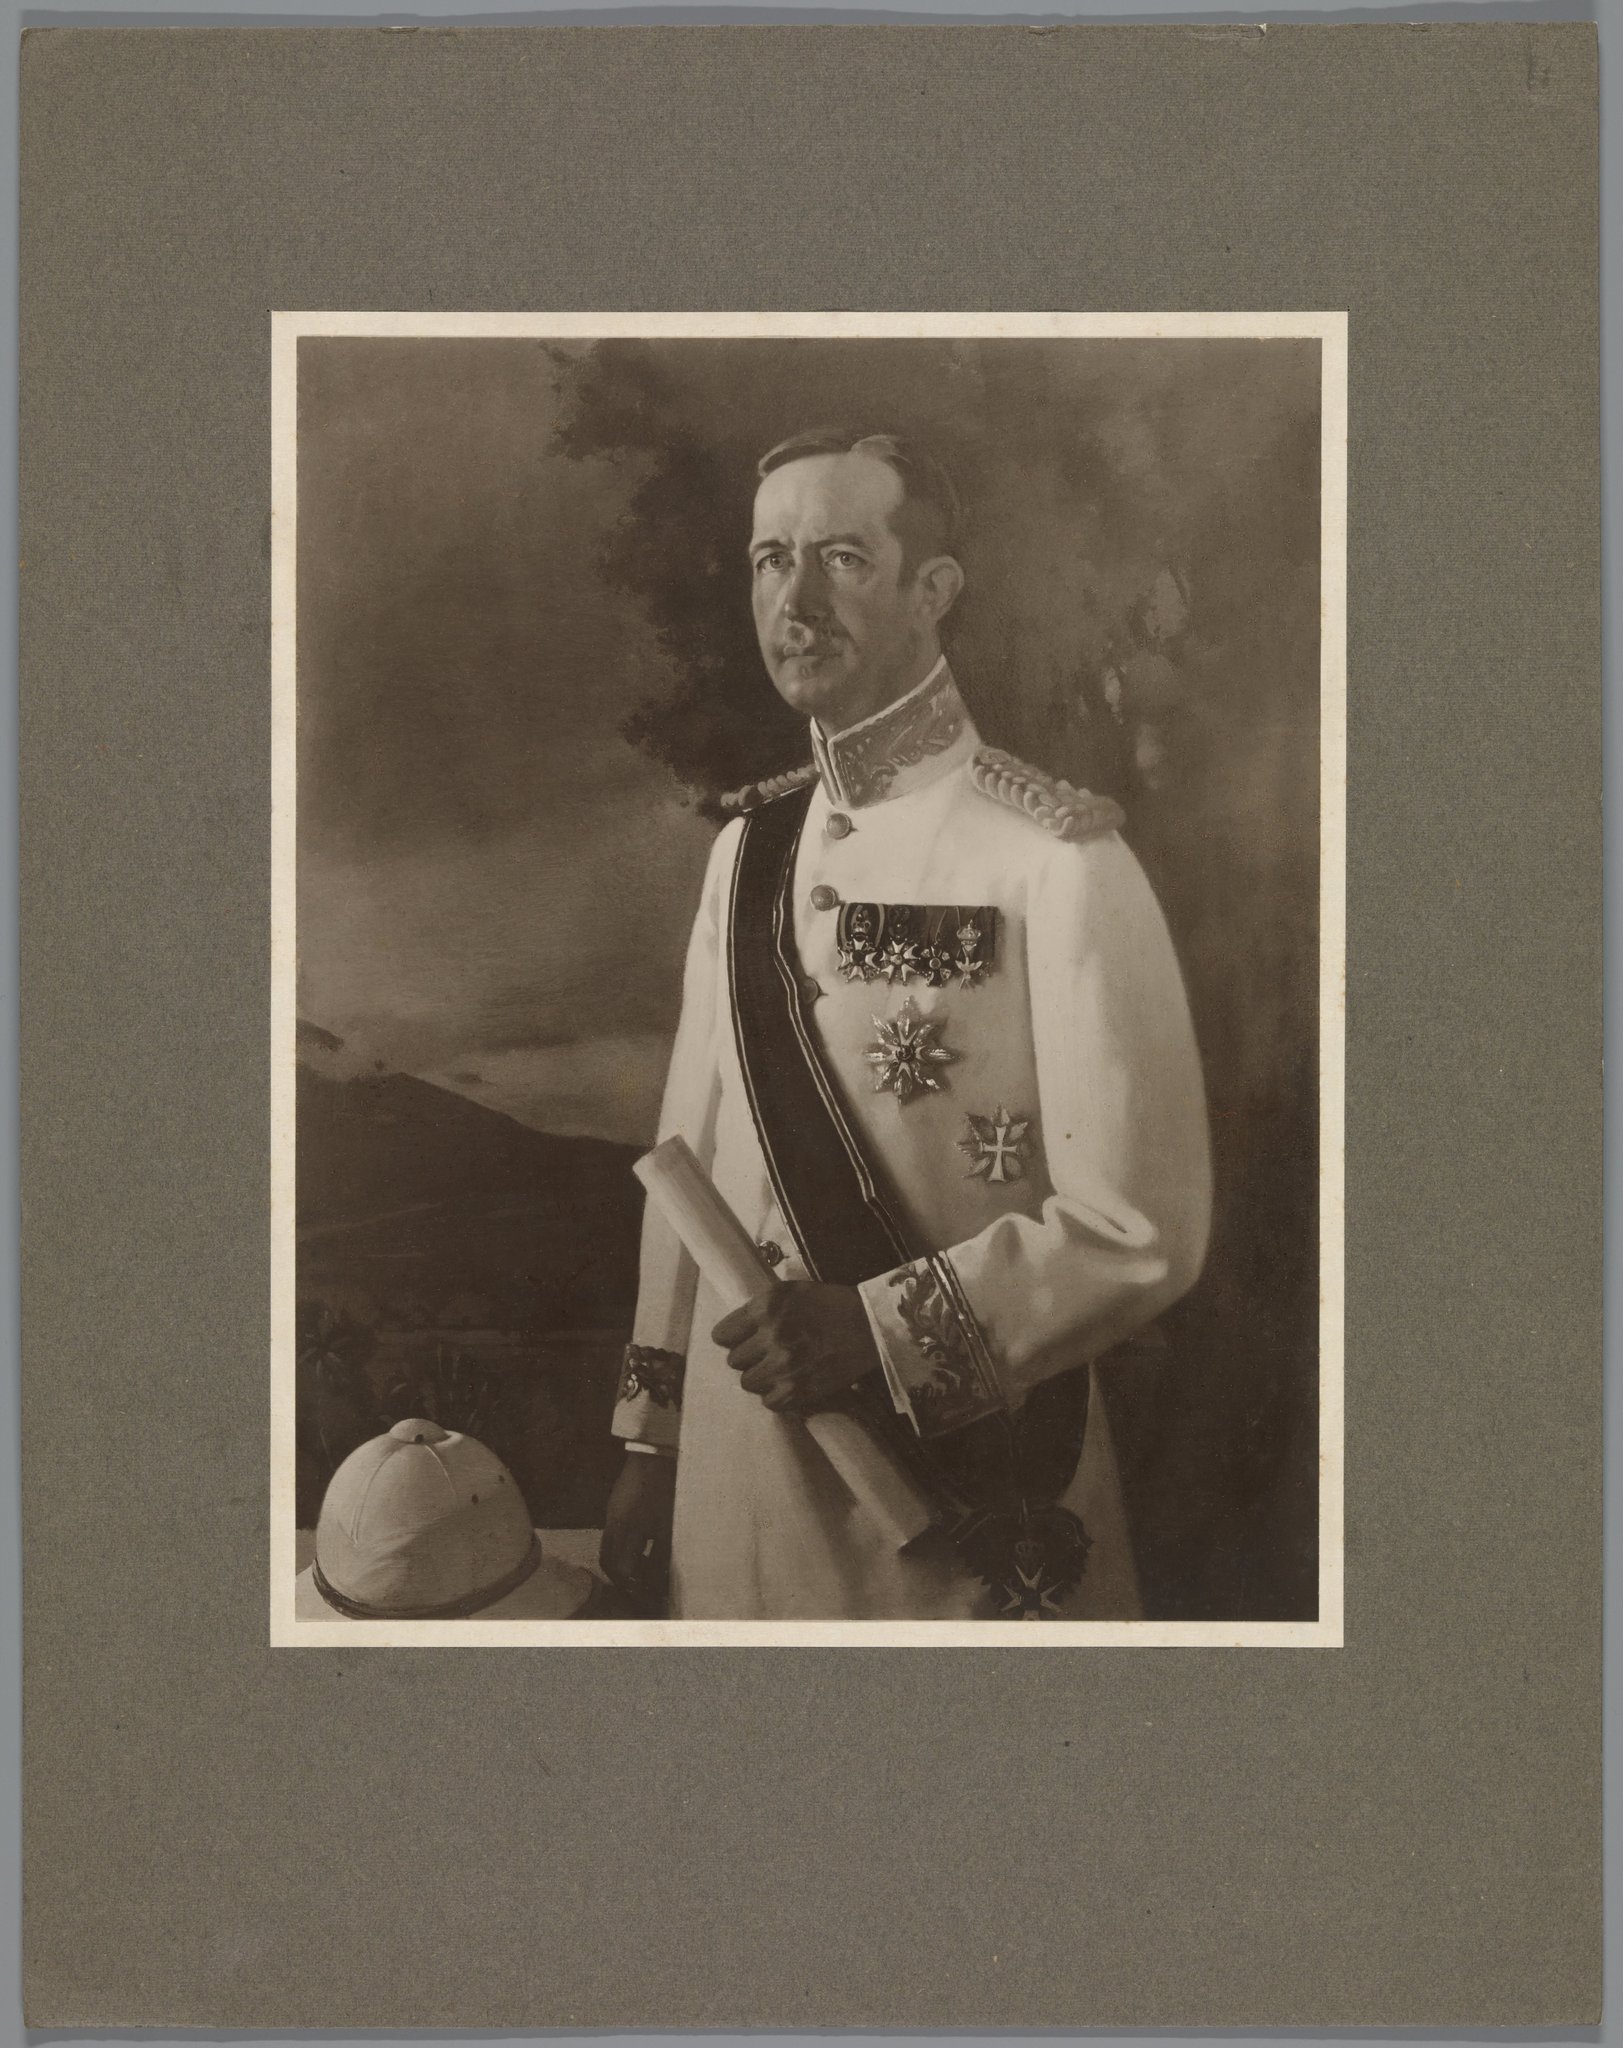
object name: photograph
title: Reproductie naar een verdwenen schilderij van Willem Witsen van een portret van J.P. van Limburg-Stirum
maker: Anonymous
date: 1860-1915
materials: cardboard, paper, photographic support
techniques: gelatin silver print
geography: netherlands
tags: zwolle, johan paul graaf van limburg stirum